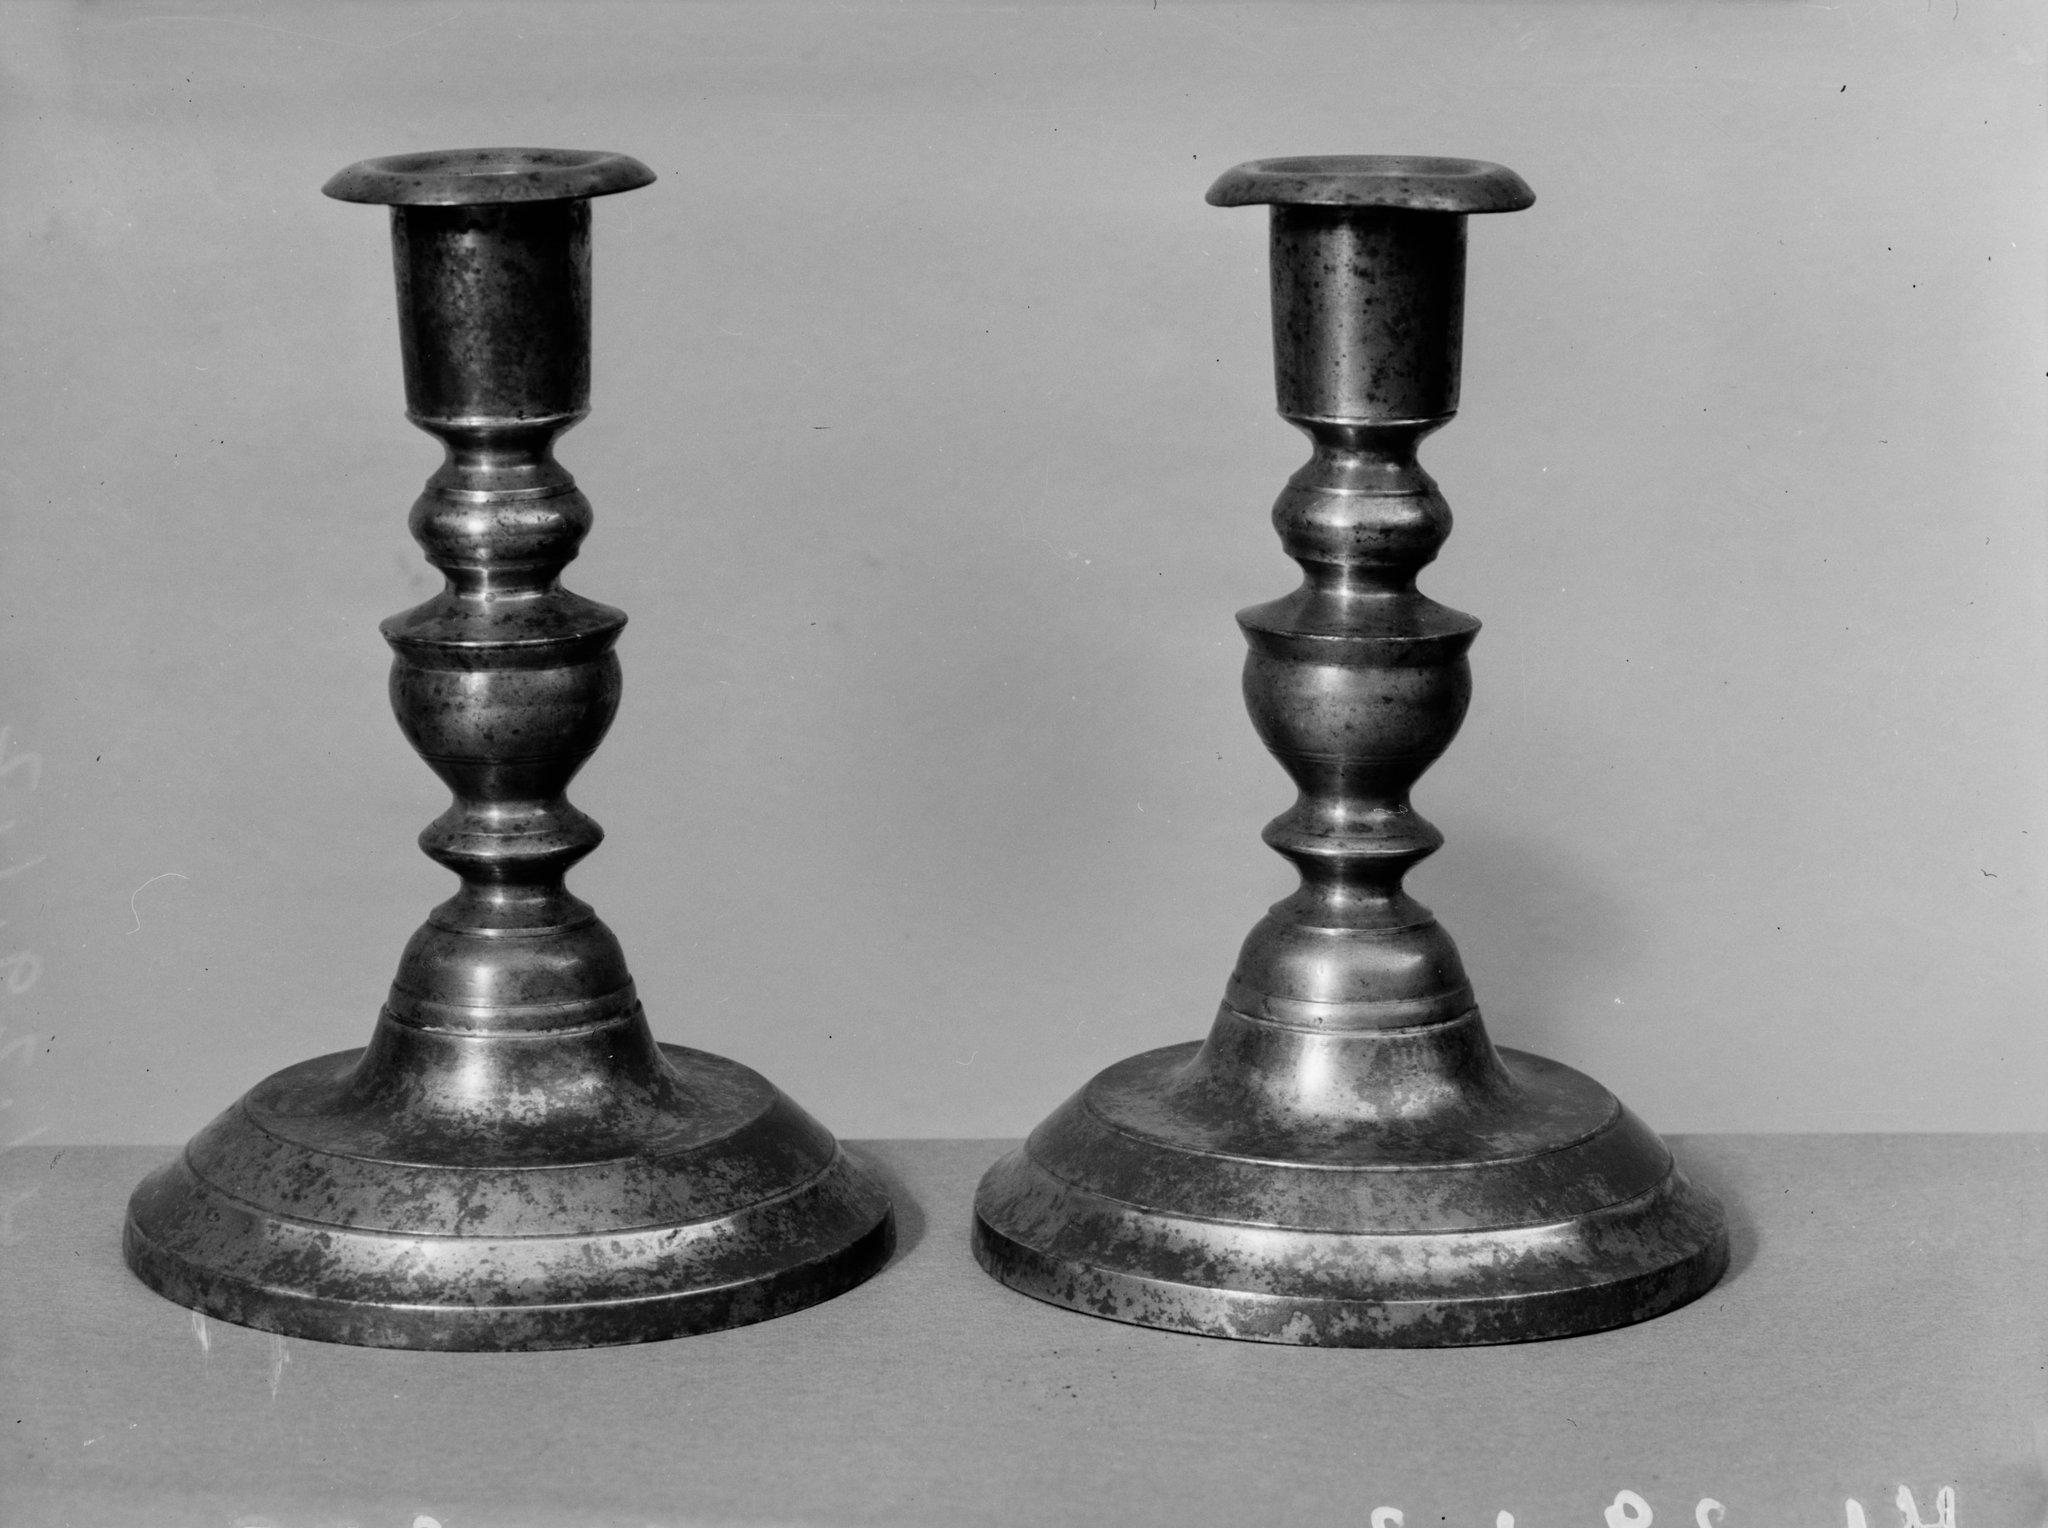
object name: candlestick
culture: american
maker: rufus dunham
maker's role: maker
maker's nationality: american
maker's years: 1815-1882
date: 1837-1860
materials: pewter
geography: united states